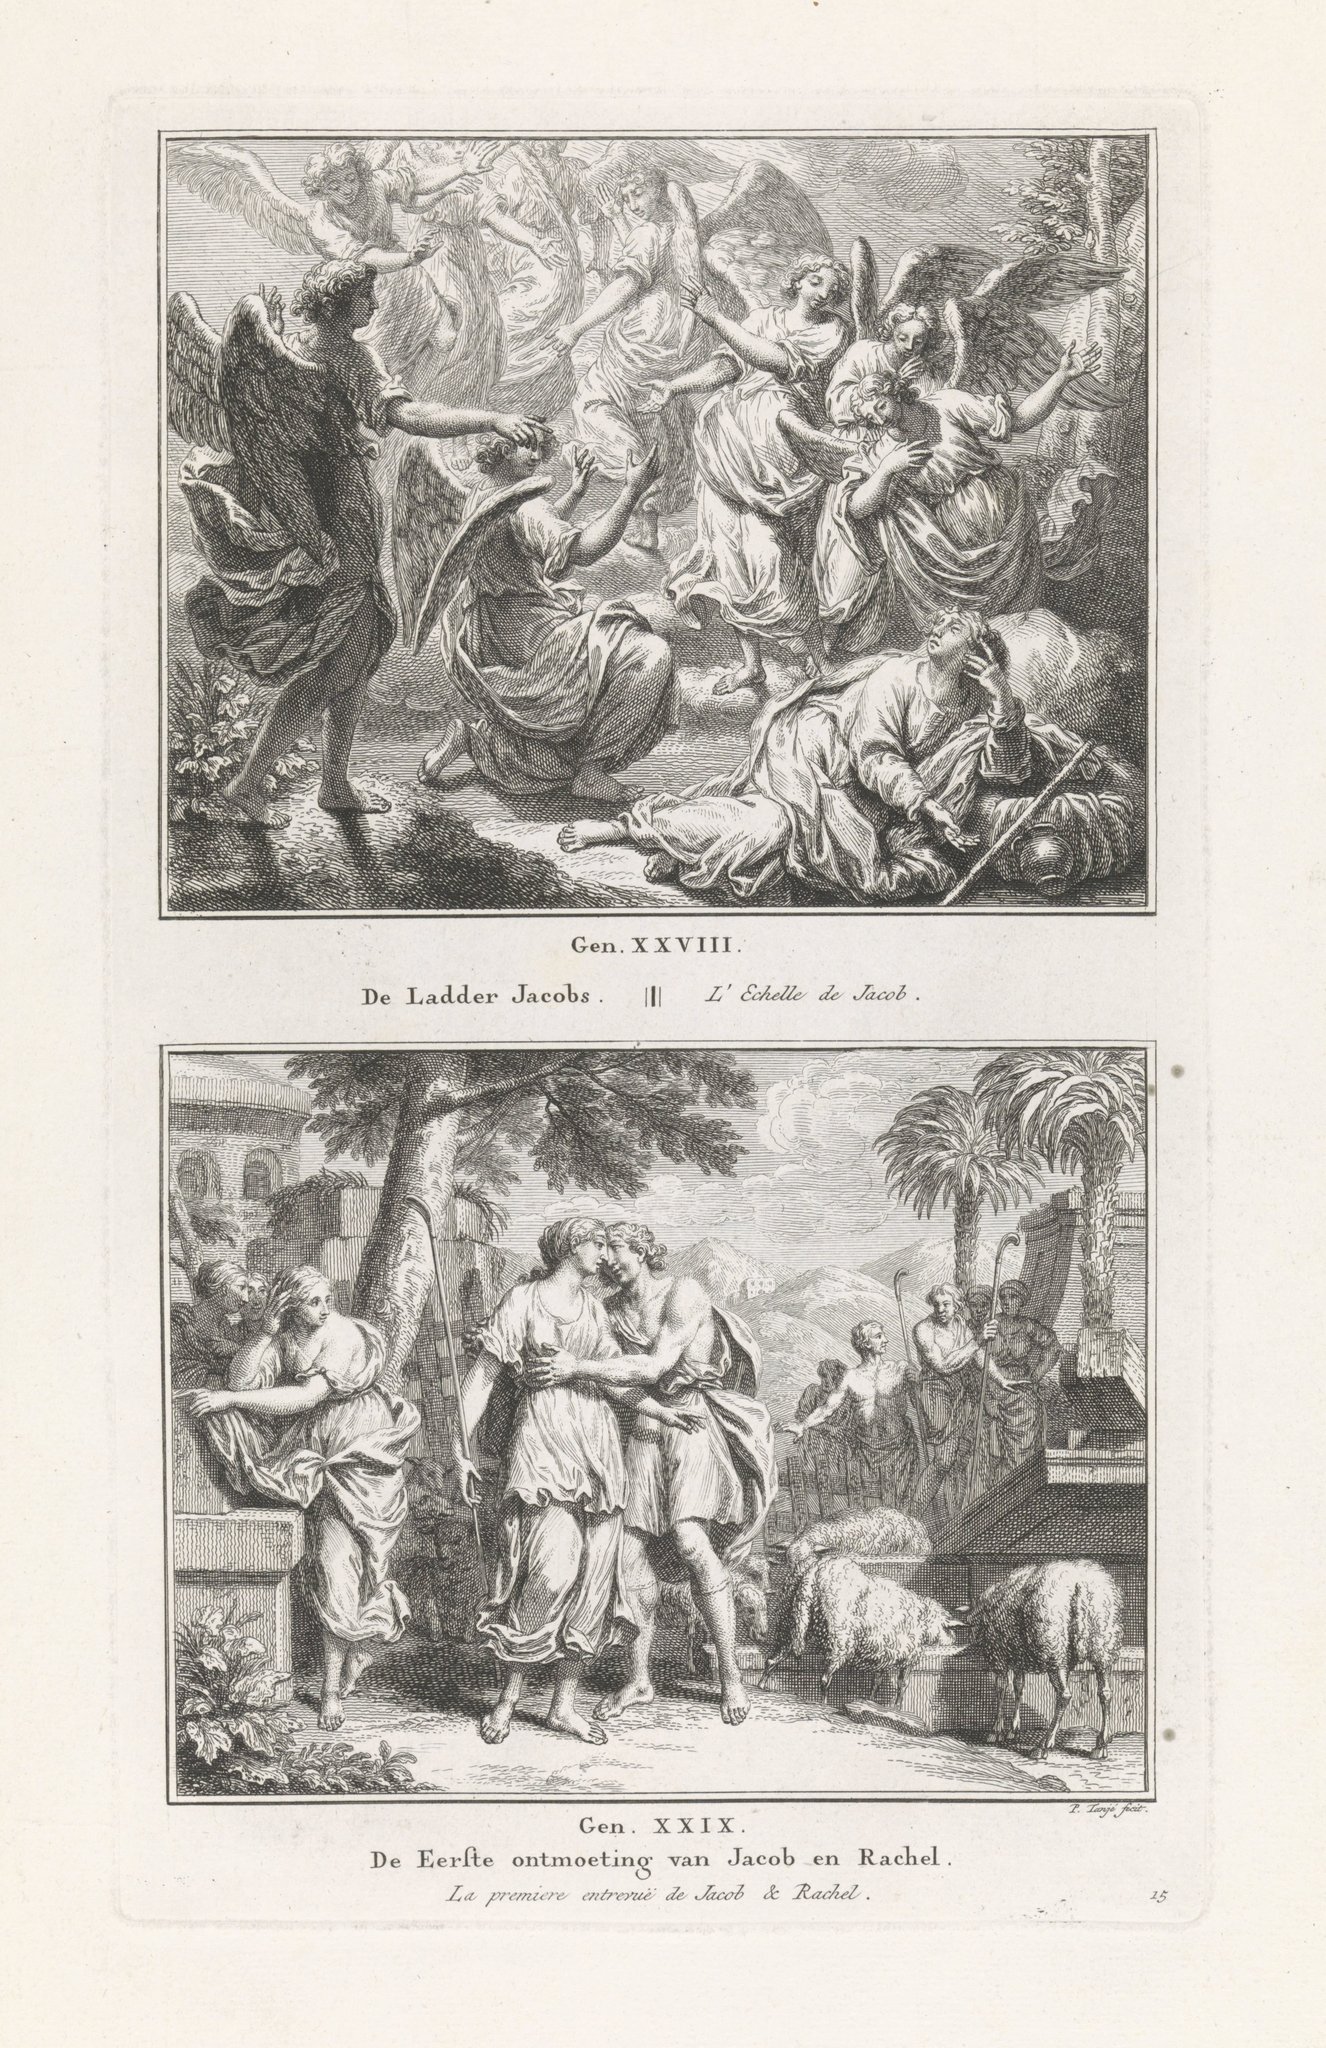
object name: print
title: De Ladder Jacobs (...) / De Eerste ontmoeting van Jacob en Rachel (...)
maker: pieter tanjé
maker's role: draughtsman, print maker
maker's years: 1706-1761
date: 1716-1761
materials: paper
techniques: engraving, etching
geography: amsterdam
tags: jacob kisses rachel and is moved to tears, the dream of jacob: while sleeping on the ground with a stone for pillow jacob sees a ladder reaching from earth to heaven with angels going up and down; usually with god at the top of the ladder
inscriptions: collector's mark: Lugt 2233, collector's mark: Lugt 3937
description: Prent mogelijk gebruikt in: Hamelsveld, Ysbrand van. De gewigtigste geschiedenissen des Bybels, afgebeeld in twee honderd twee en vĳftig printverbeeldingen (...) met eene zaaklĳke uitbreiding opgehelderd. Amsterdam: Jan de Groot, Gerrit Warnars, Petrus van Hengst, Dordrecht: Abraham Blussé, Pieter Blussé, Leiden: Samuel Luchtmans (III), Johannes Luchtmans, Harlingen: Volkert van der Plaats, 1791.